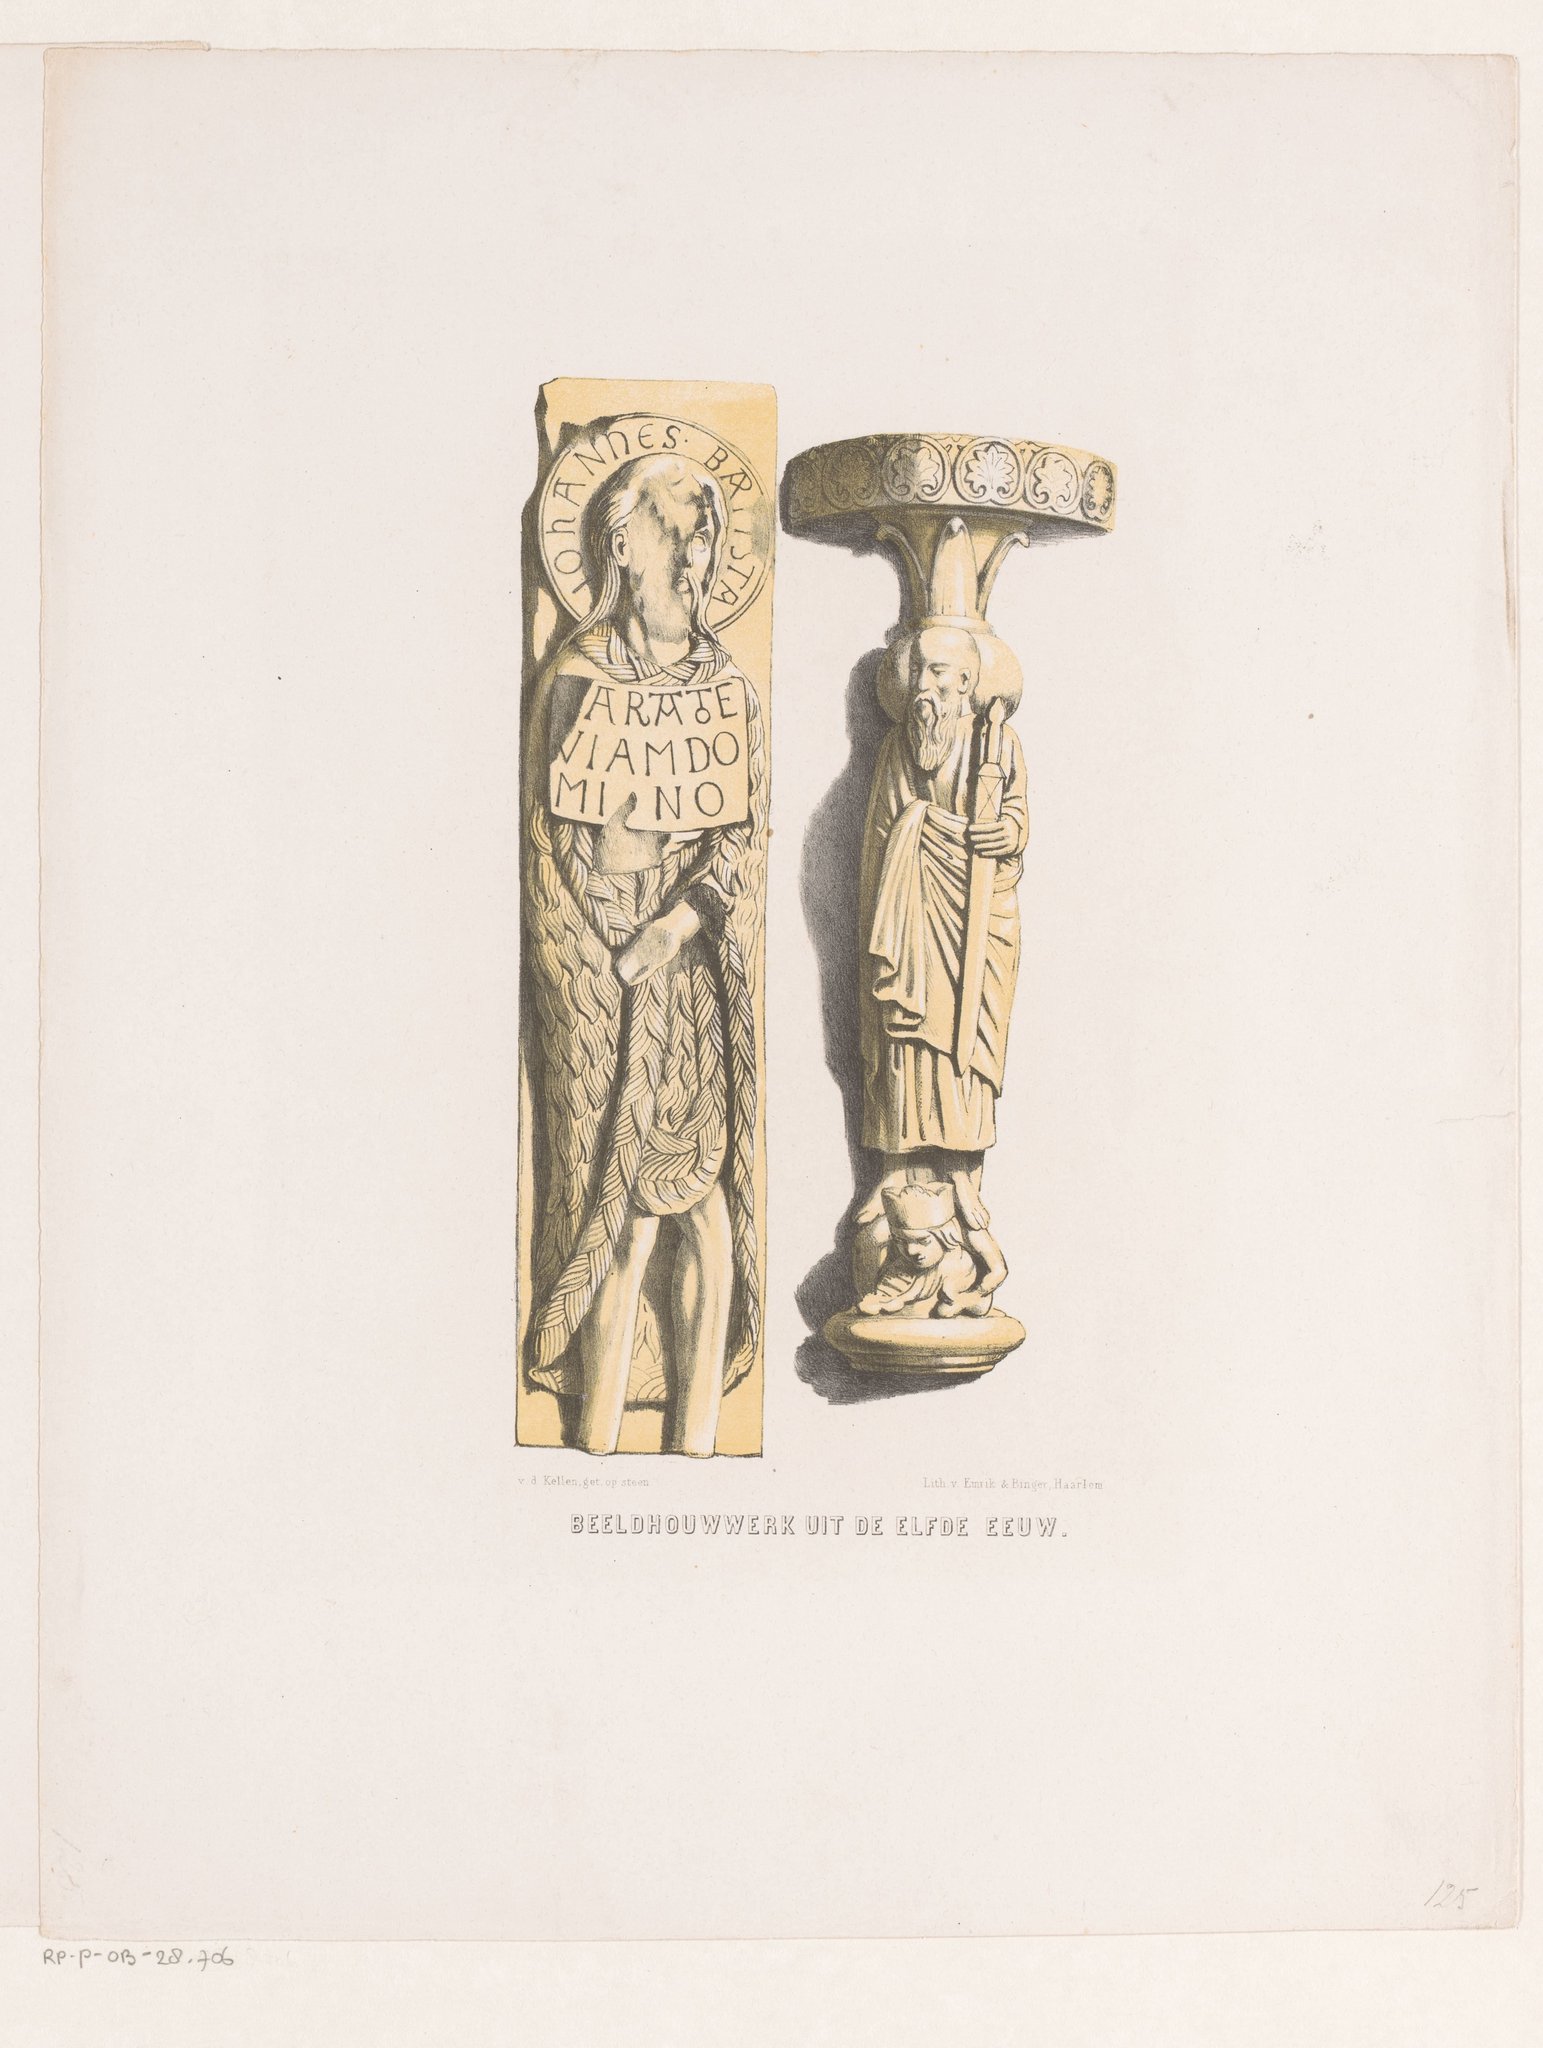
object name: historical object representation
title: Beeldhouwwerk, 11e eeuw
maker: david van der kellen (1827-1895)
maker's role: draughtsman, print maker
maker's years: 1827-1895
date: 1857-1864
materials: paper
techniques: tone lithography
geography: haarlem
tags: monument, statue, netherlands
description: Illustratie voor: W.J. Hofdijk, Ons voorgeslacht in zijn dagelyksch leven geschilderd, Kruseman, Haarlem 1859-1864.